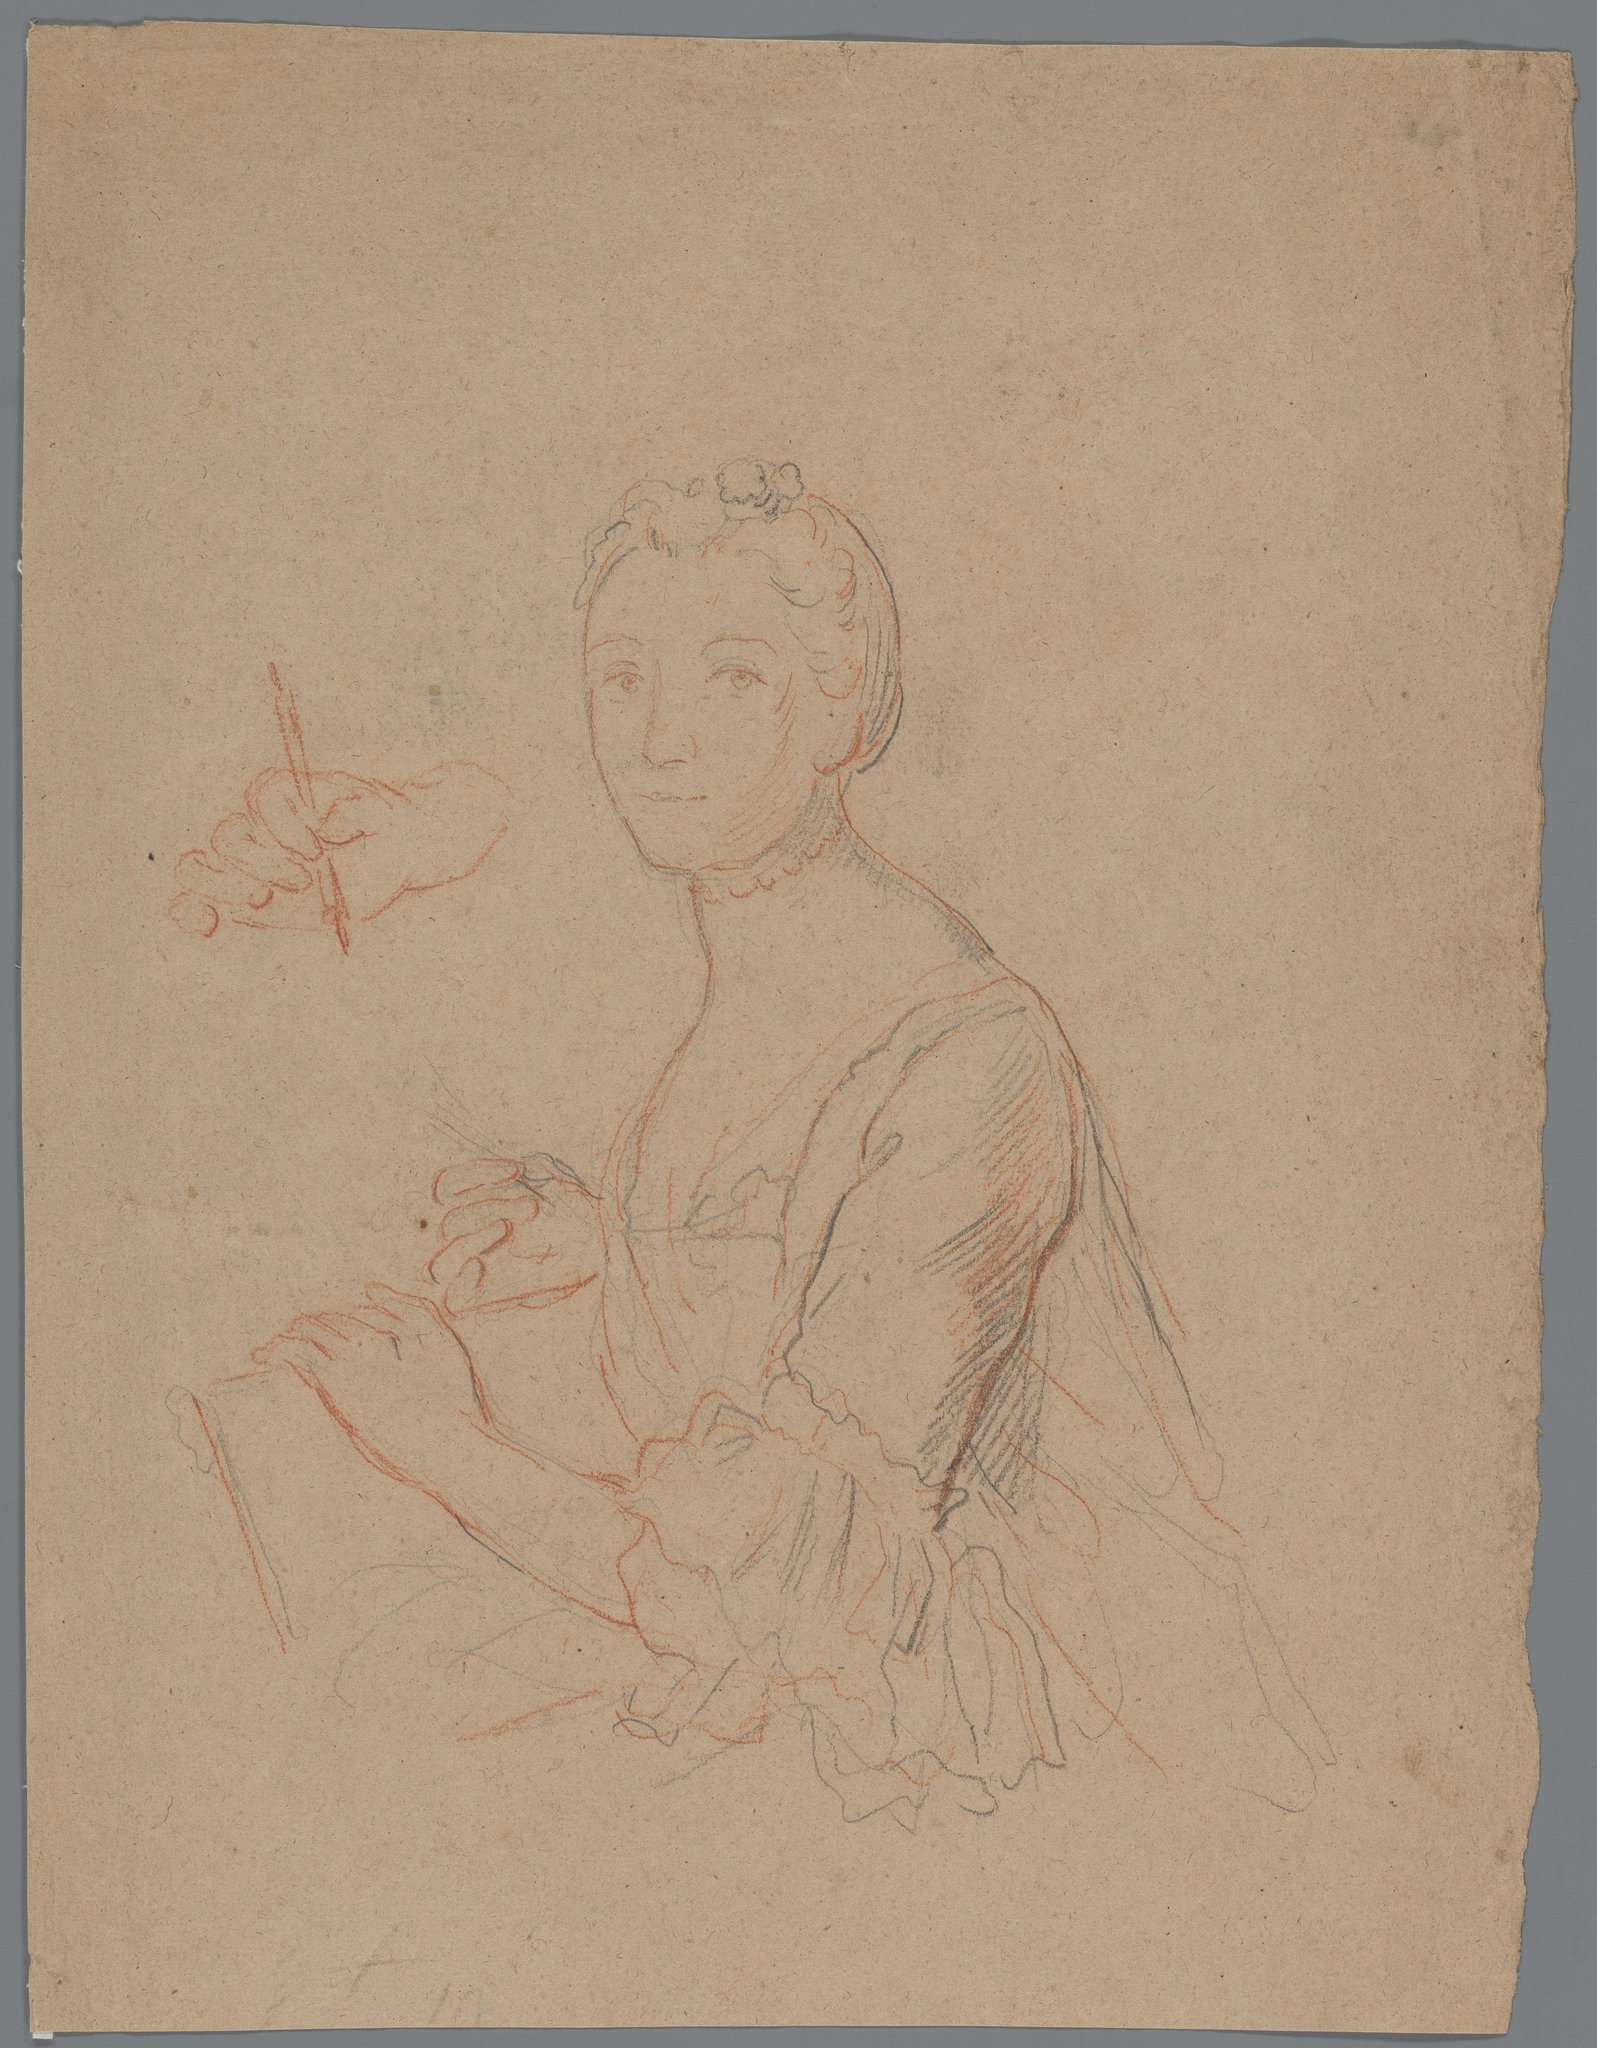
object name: drawing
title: Portret van een dame met papier en stift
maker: Anonymous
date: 1700-1800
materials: chalk, paper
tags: portrait, self-portrait of draughtsman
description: Portret van een dame met papier en stift; haar hand met de stift nogmaals afzonderlijk herhaald.